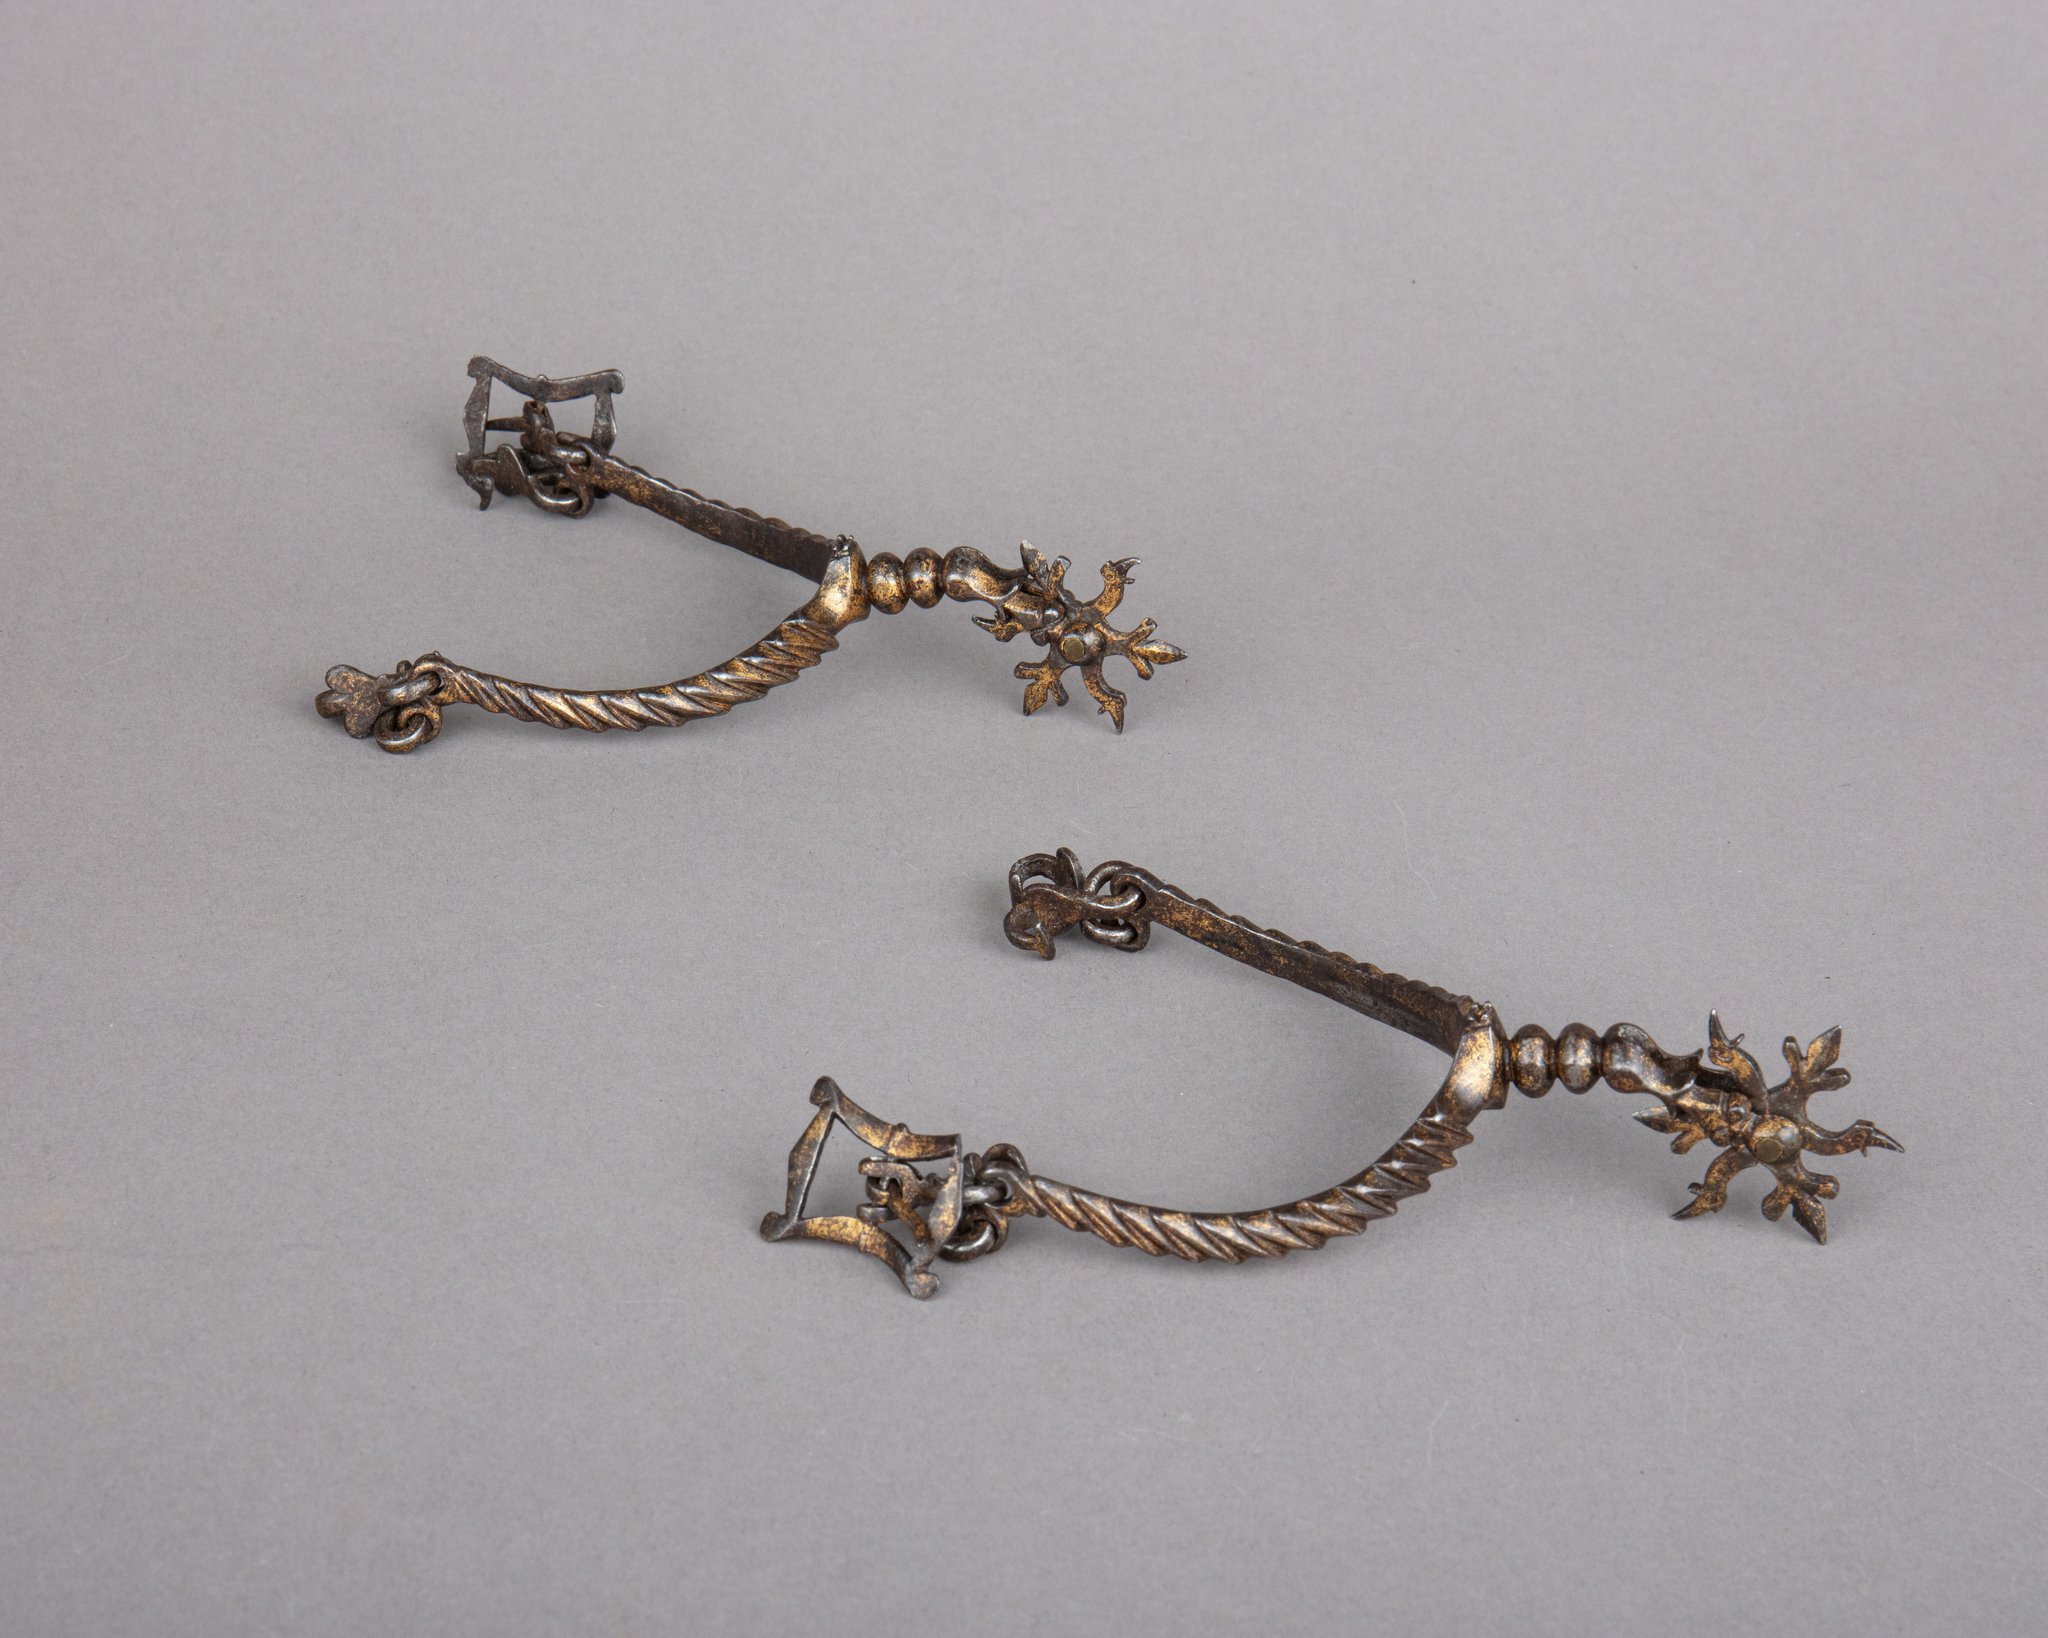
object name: spur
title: Pair of Rowel Spurs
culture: german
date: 1601-1700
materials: gold, metal alloy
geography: germany